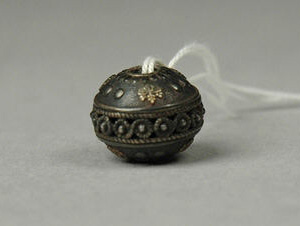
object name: ojime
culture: japanese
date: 1801-1900